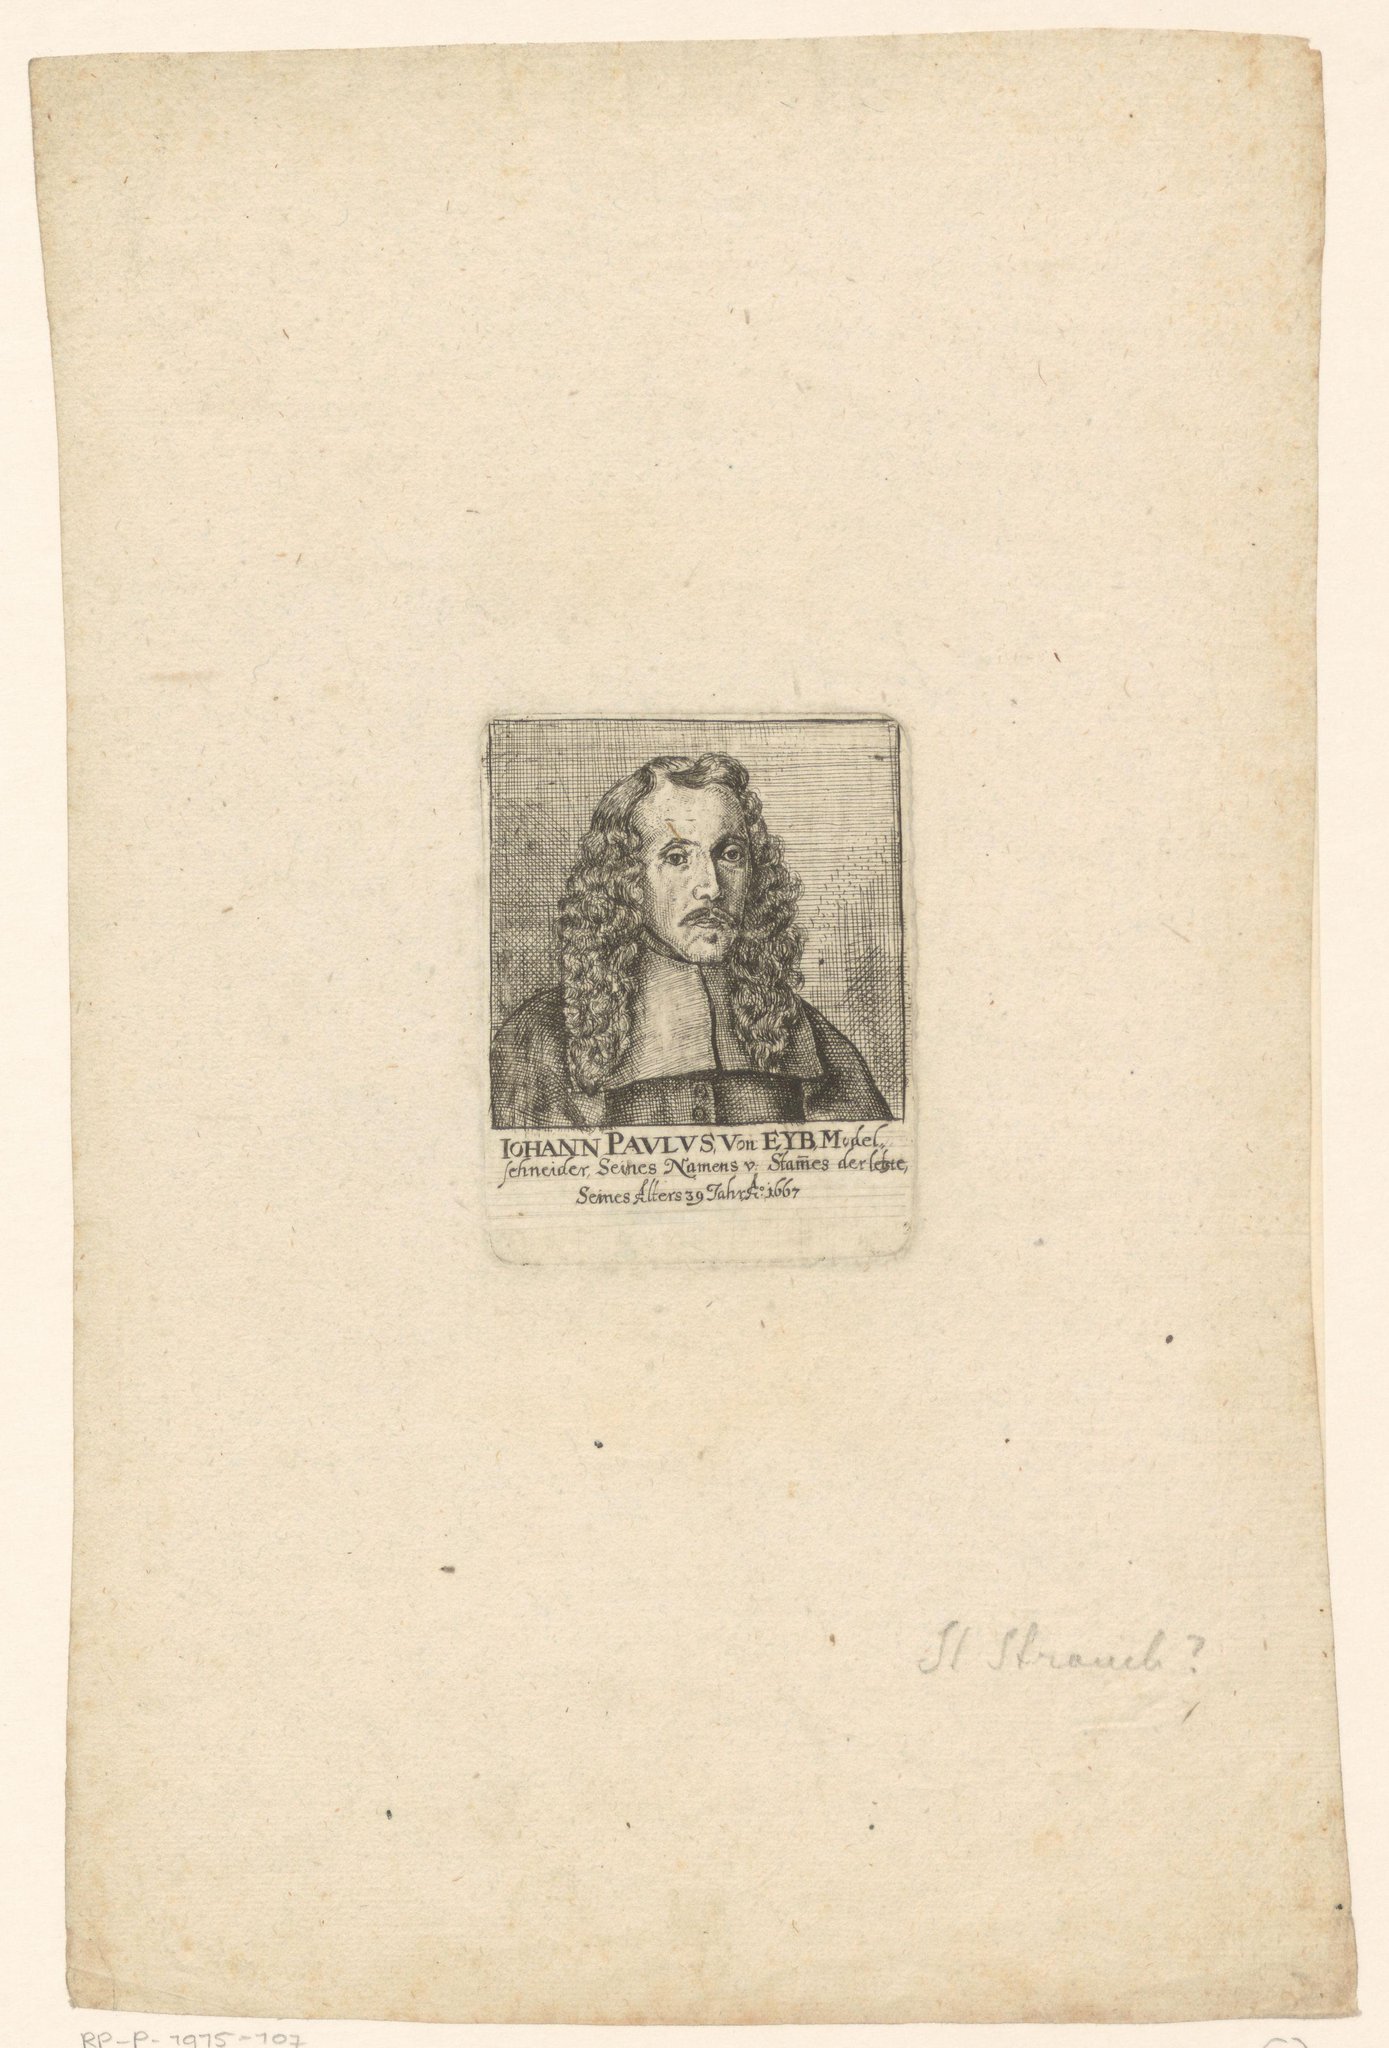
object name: print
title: Portret van Johann Paul von Eyb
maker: stephan strauch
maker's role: painter, print maker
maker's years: 1645-1677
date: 1667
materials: paper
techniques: etching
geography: nuremberg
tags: johann paul von eyb, historical persons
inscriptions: collector's mark: Lugt 2228